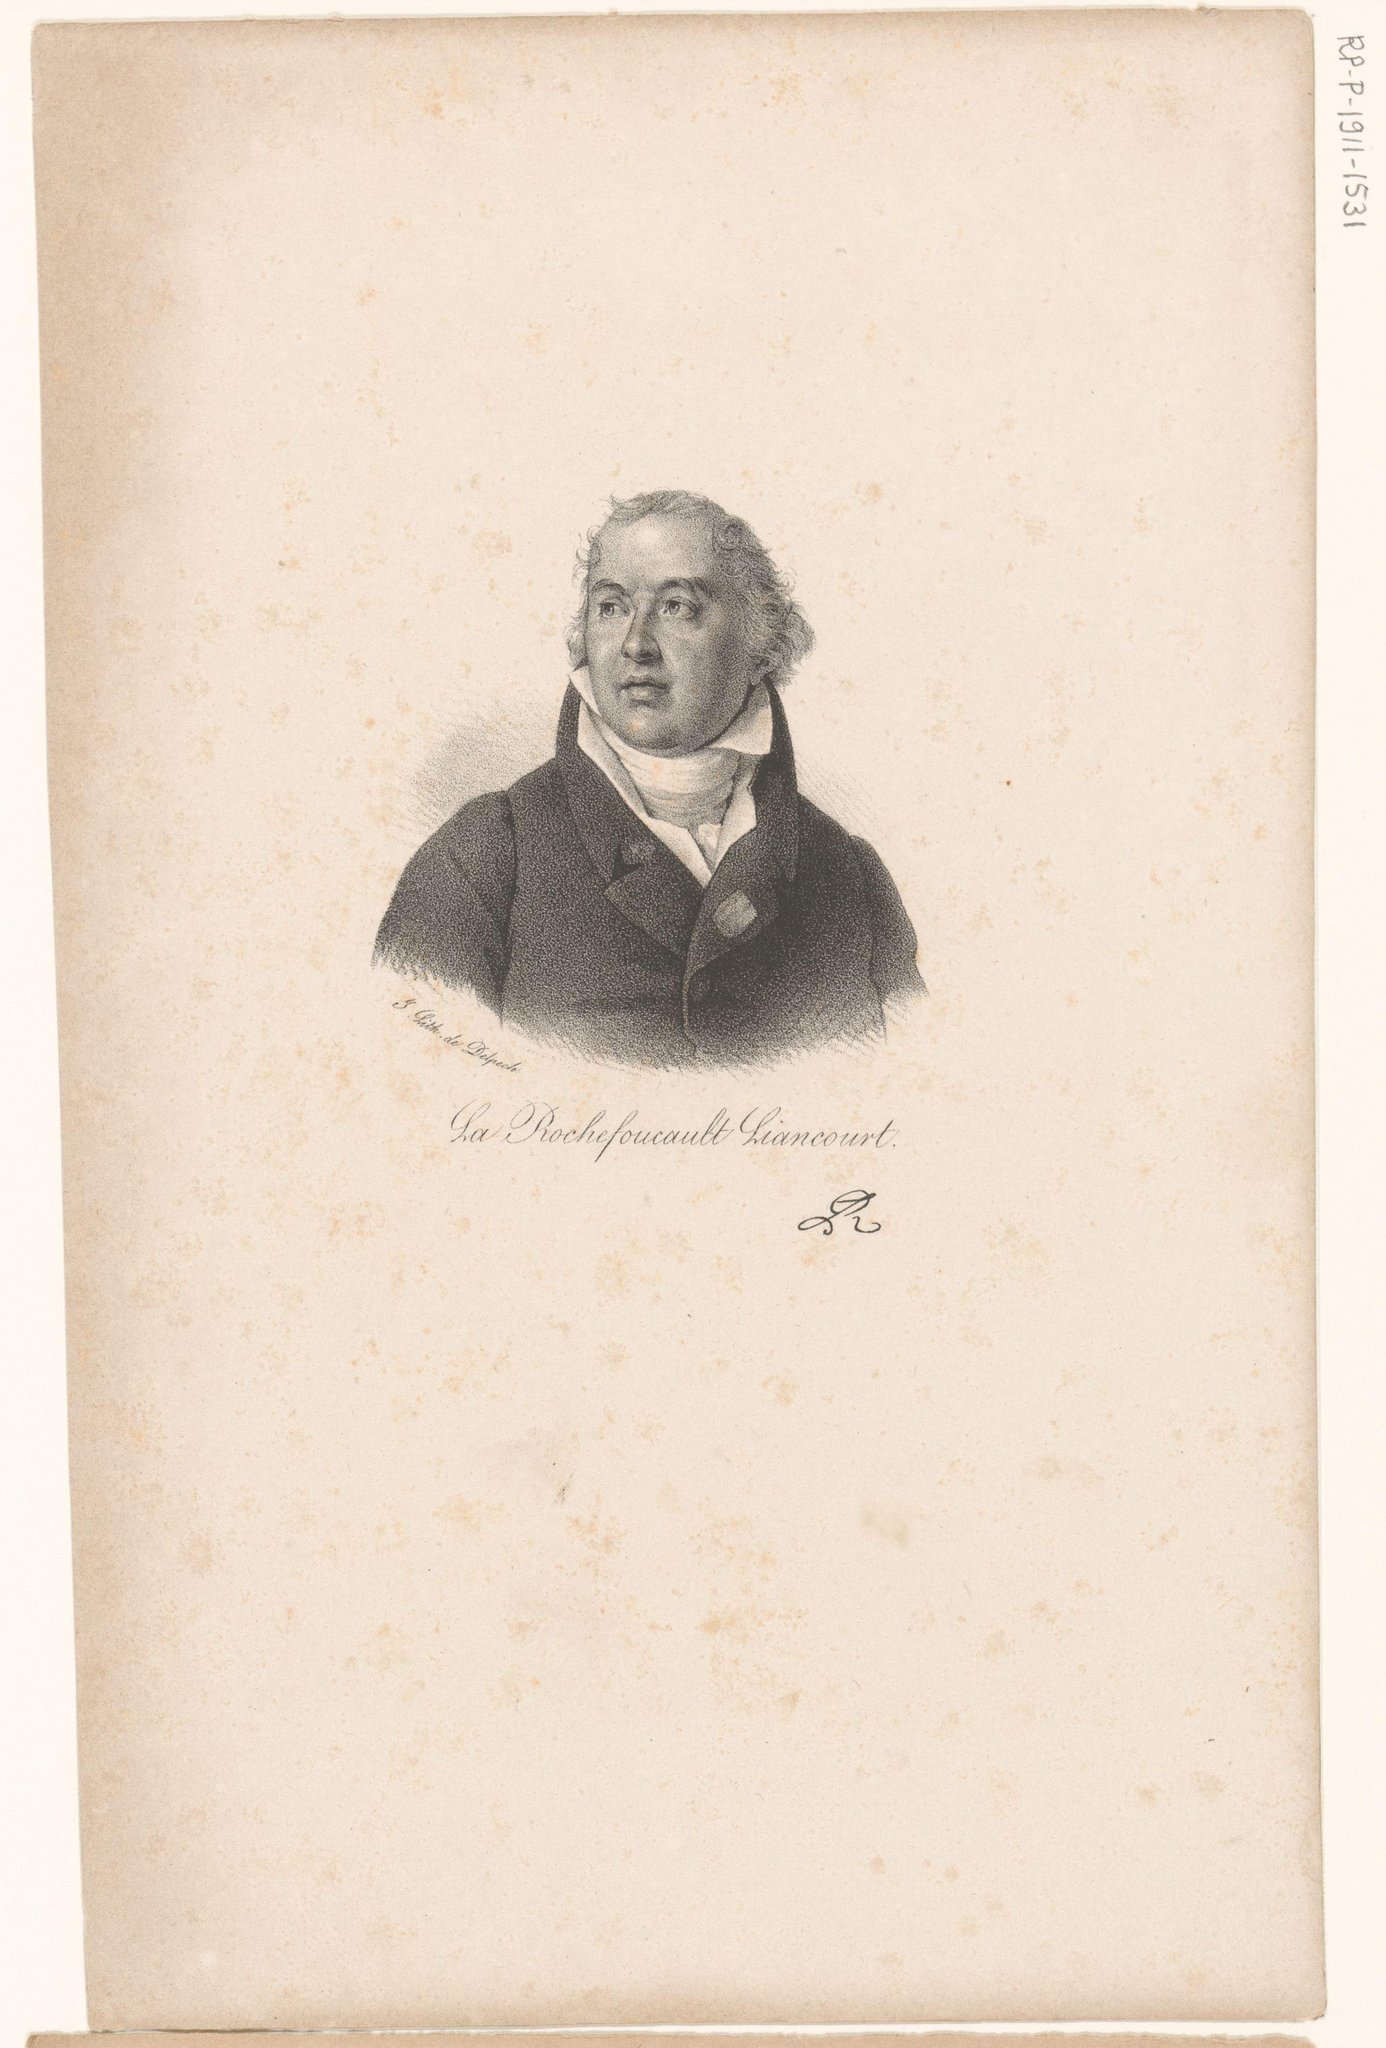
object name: print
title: Portret van François XII de La Rochefoucauld-Liancourt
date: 1818-1842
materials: paper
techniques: lithograph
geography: paris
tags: paris, politician, historical persons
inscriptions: collector's mark: Lugt 2228a